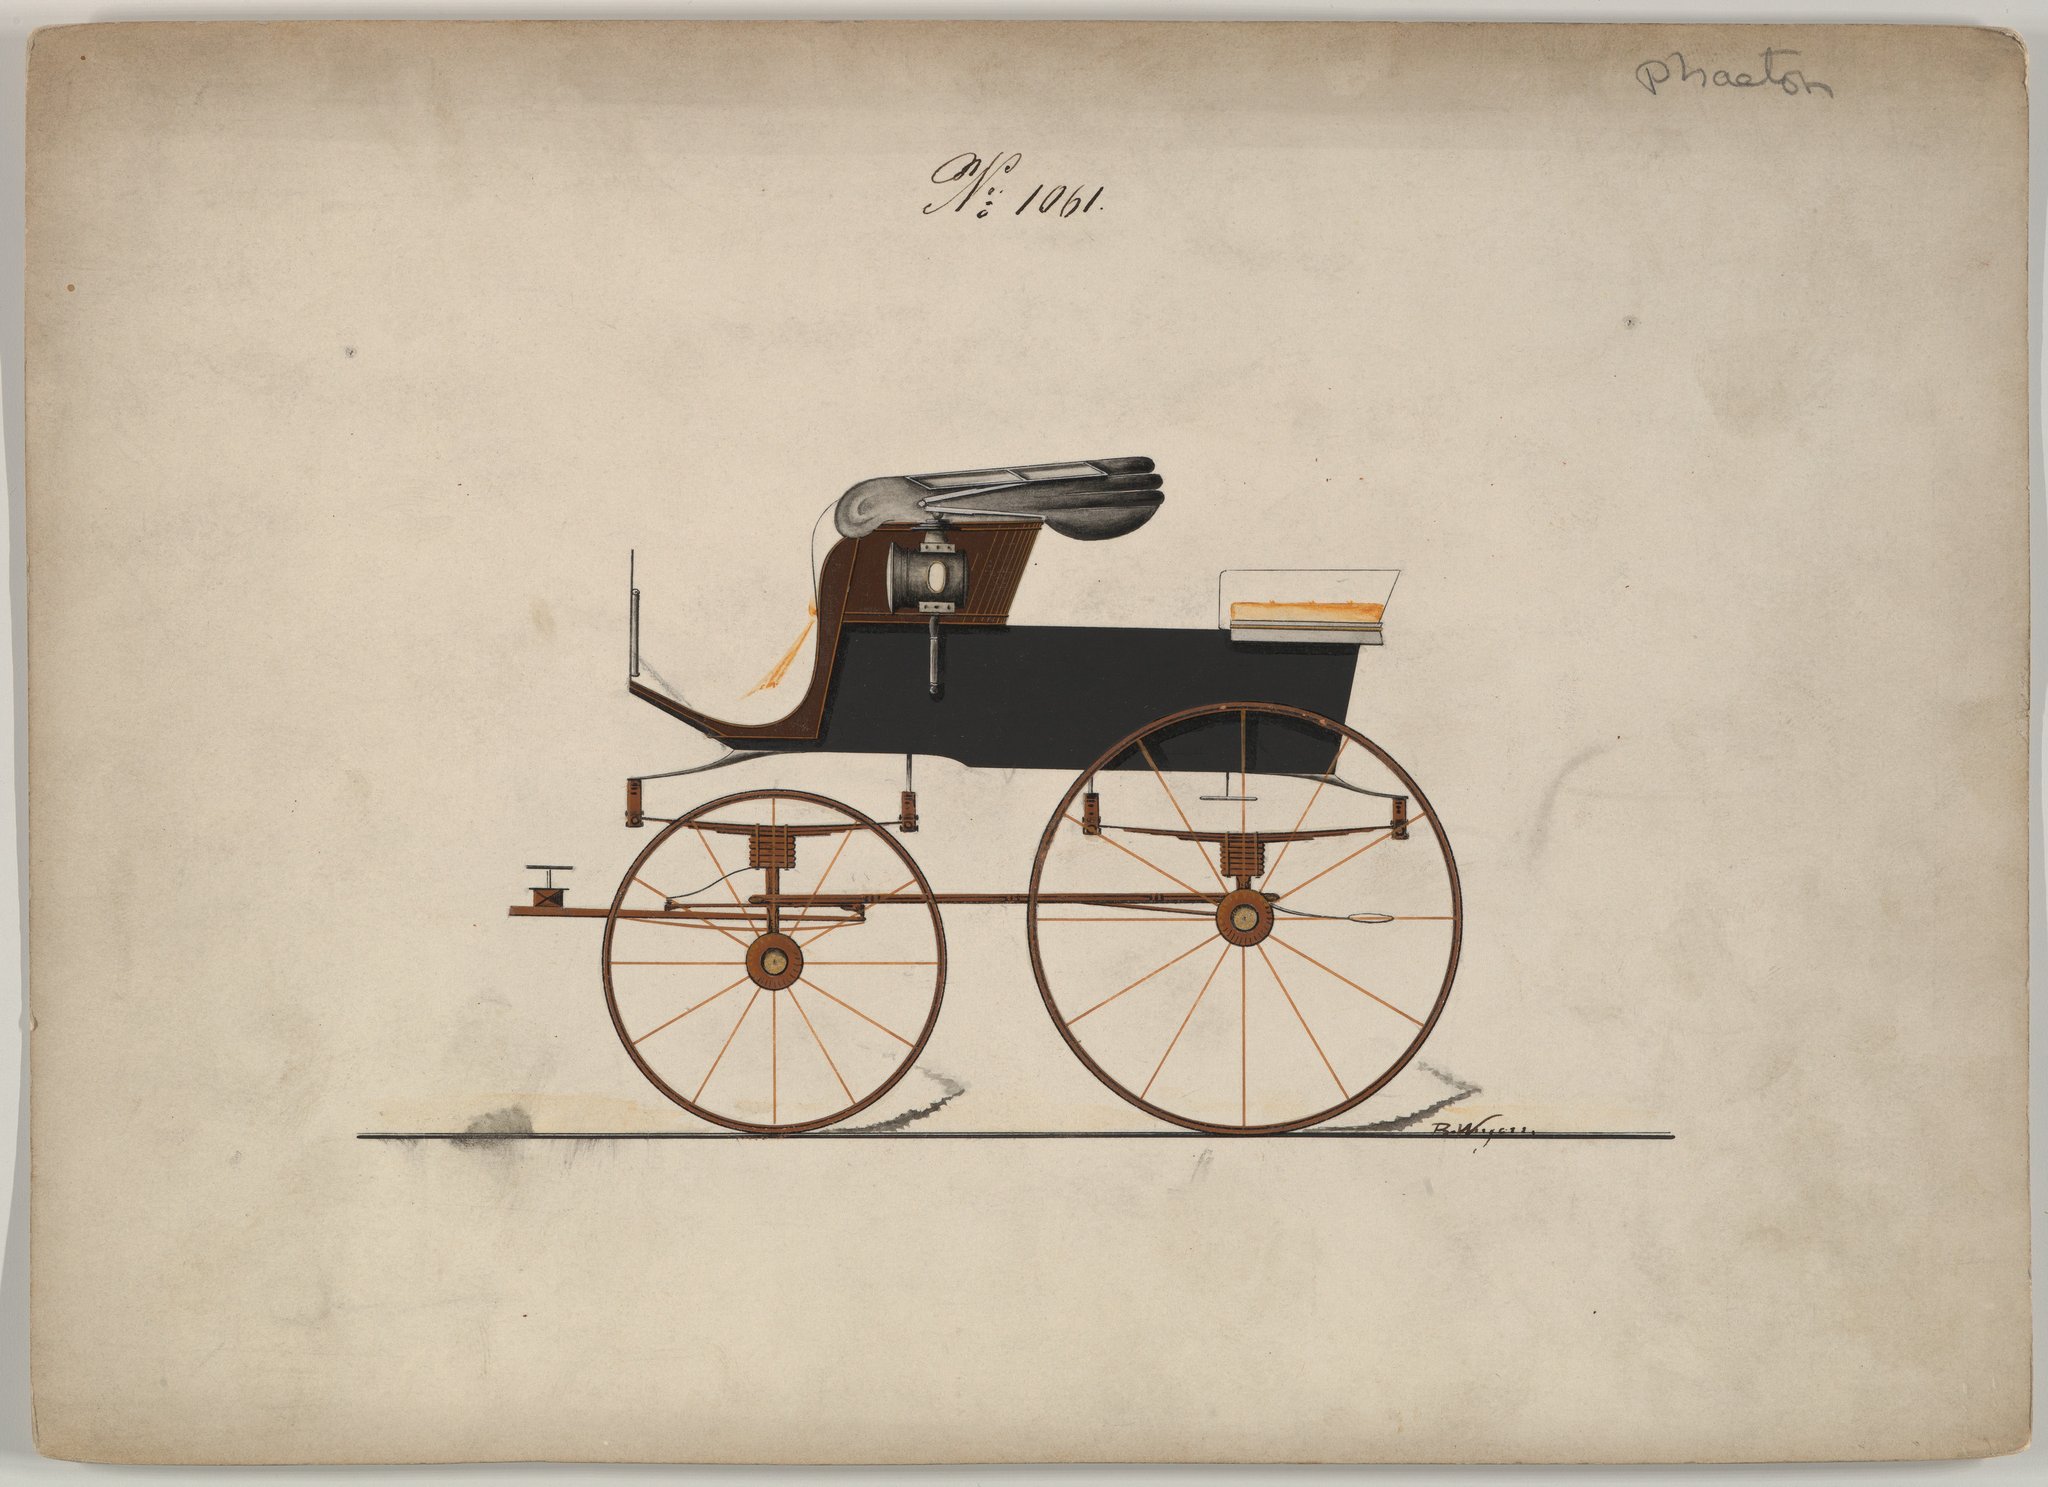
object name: drawing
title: Design for Stanhope Phaeton, no. 1061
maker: brewster & co.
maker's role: manufacturer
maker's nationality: american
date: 1850-1874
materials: gouache, ink, watercolor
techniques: pen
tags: carriages